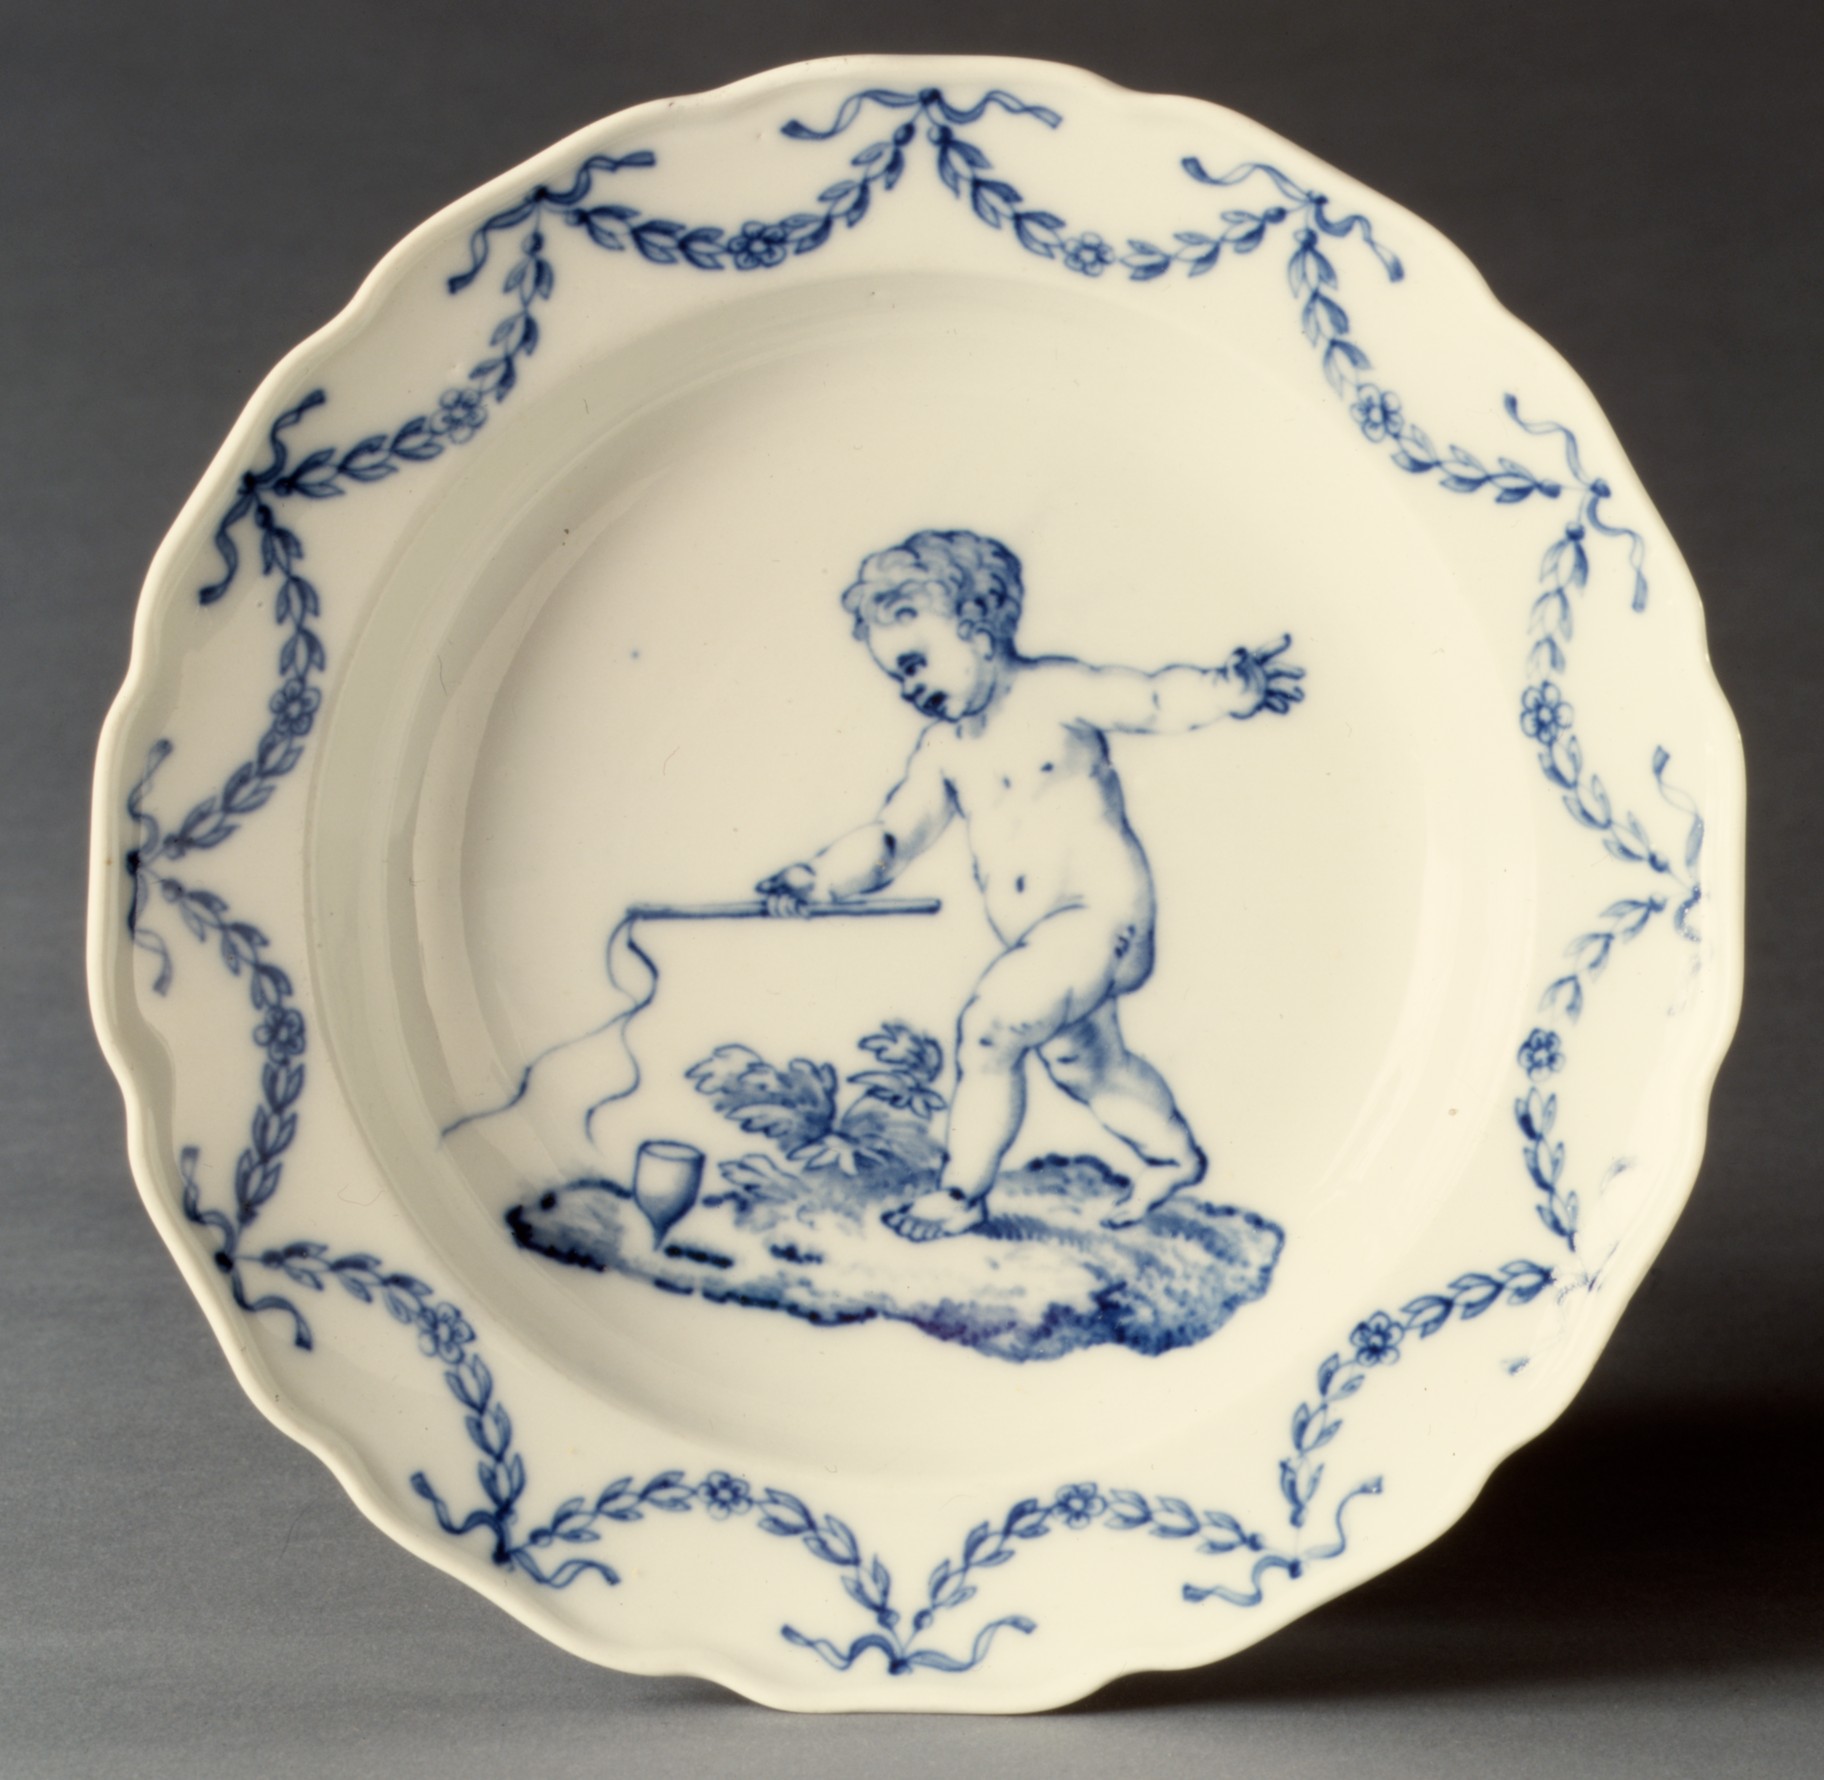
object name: soup plate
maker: meissen manufactory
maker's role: manufactory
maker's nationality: german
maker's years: 1710-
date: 1765-1770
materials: hard paste porcelain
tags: children